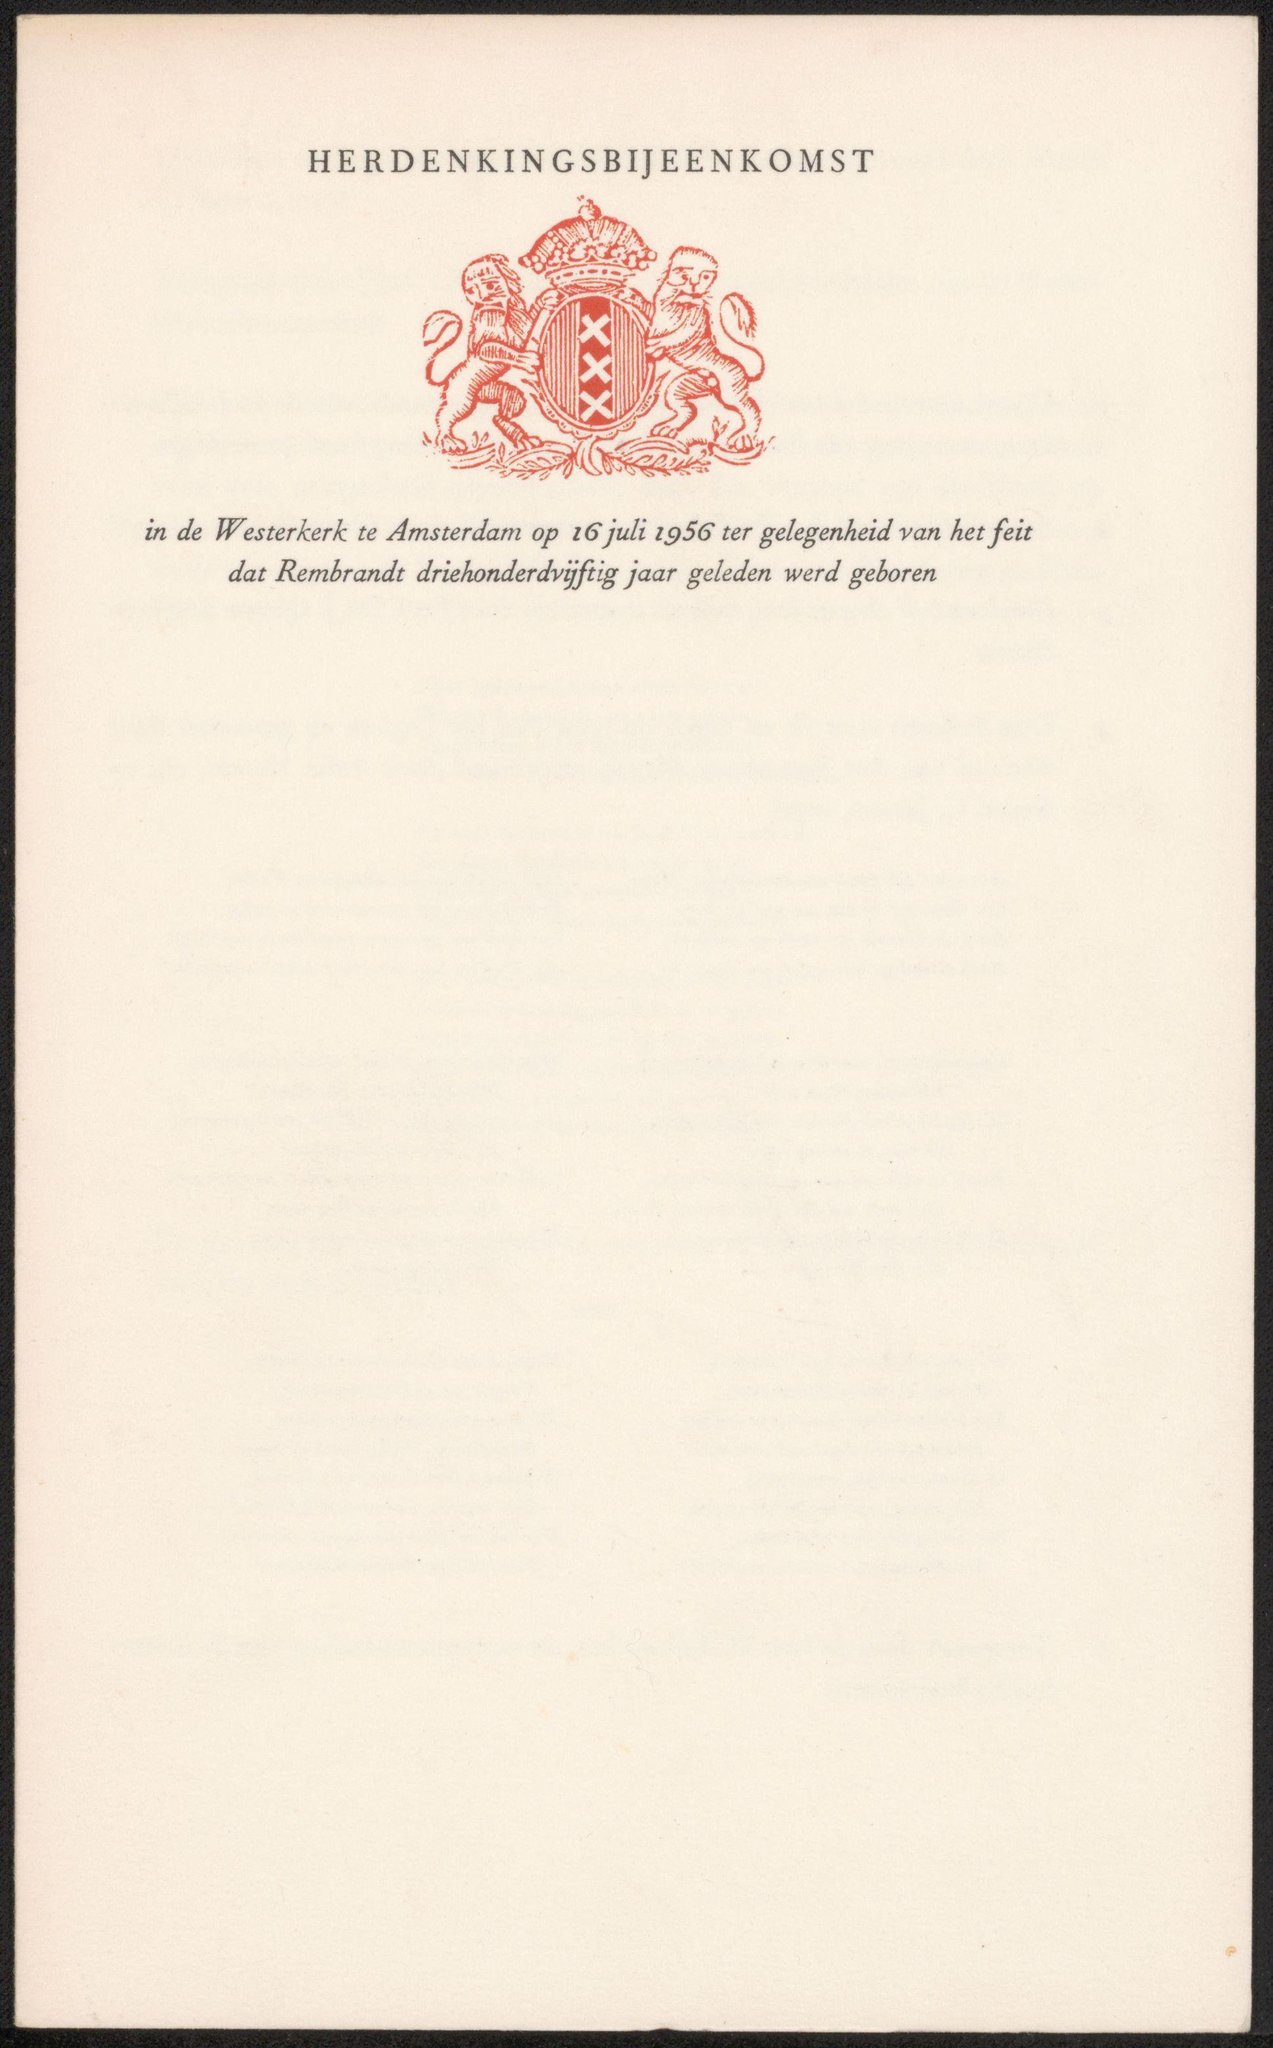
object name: programma, programmaboekje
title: Programma's van de herdenkingsbijeenkomst ter gelegenheid van de driehonderdvijftigste verjaardag van Rembrandt Harmensz. van Rijn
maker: Anonymous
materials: paper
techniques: printing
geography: amsterdam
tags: leiden, rembrandt van rijn, deventer, painter, oskar kokoschka, iohan quirijn van regteren altena, designer, charles roelofsz, amsterdam, print maker, draughtsman, jan luyken, music